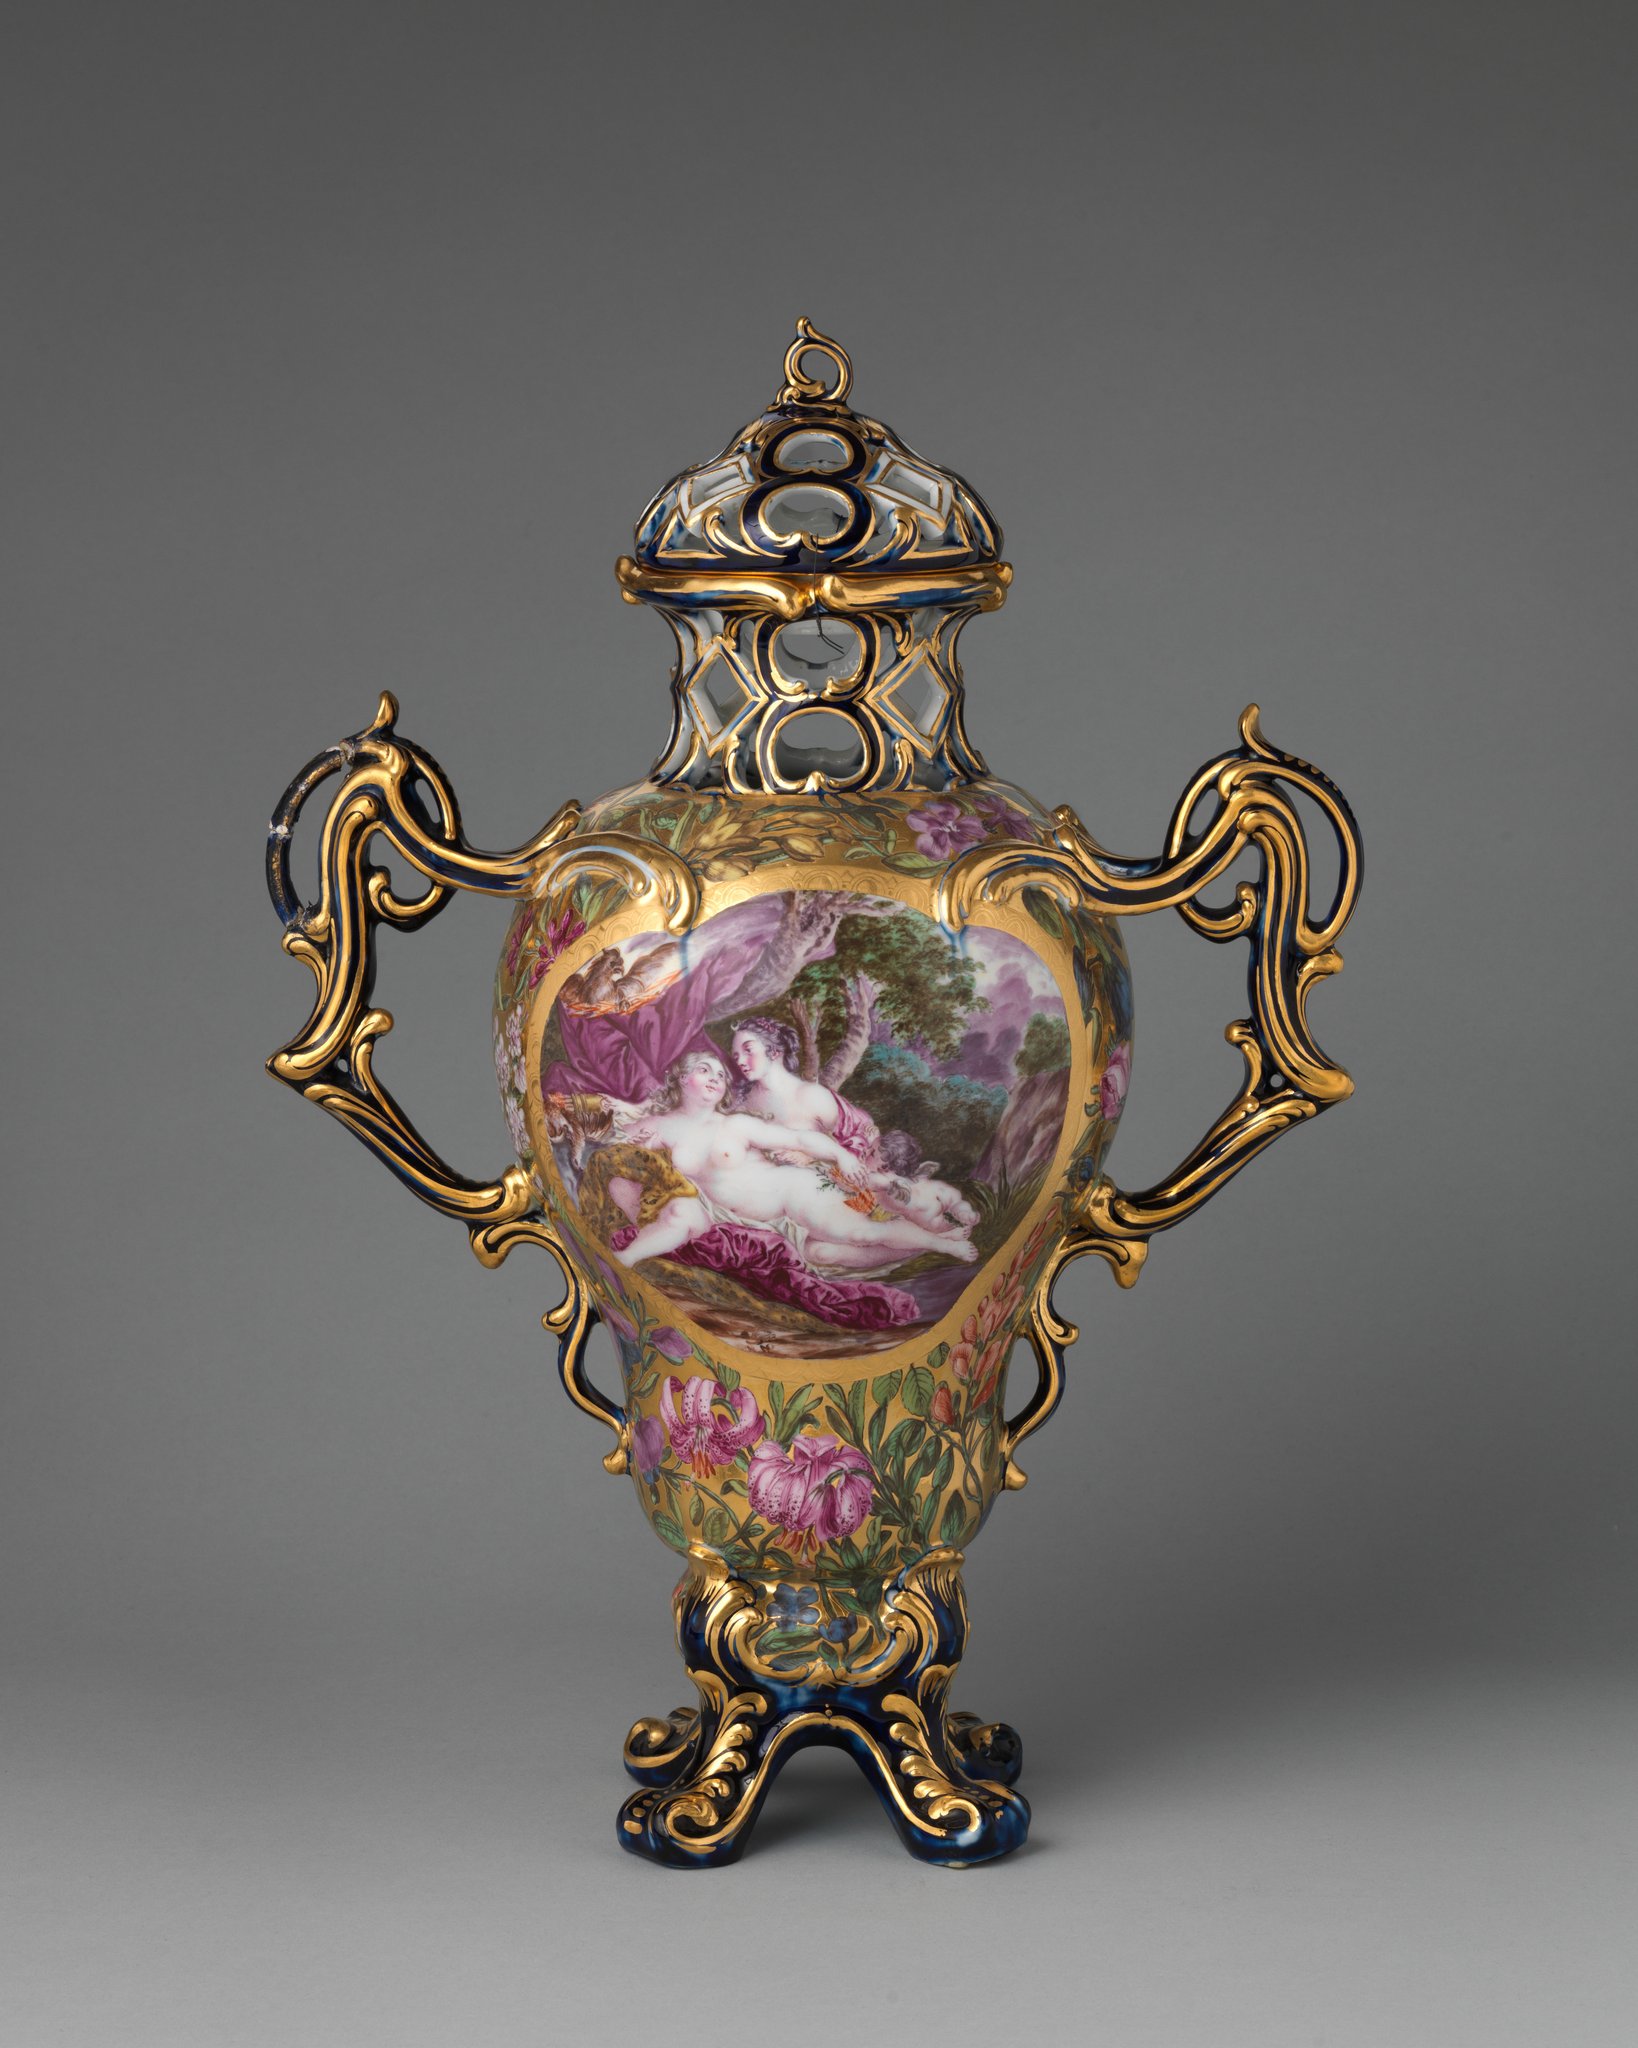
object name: perfume vase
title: Perfume vase (one of a pair)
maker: chelsea porcelain manufactory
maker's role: factory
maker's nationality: british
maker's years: 1744-1784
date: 1761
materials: gold leaf, soft paste porcelain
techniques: burnishing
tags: female nudes